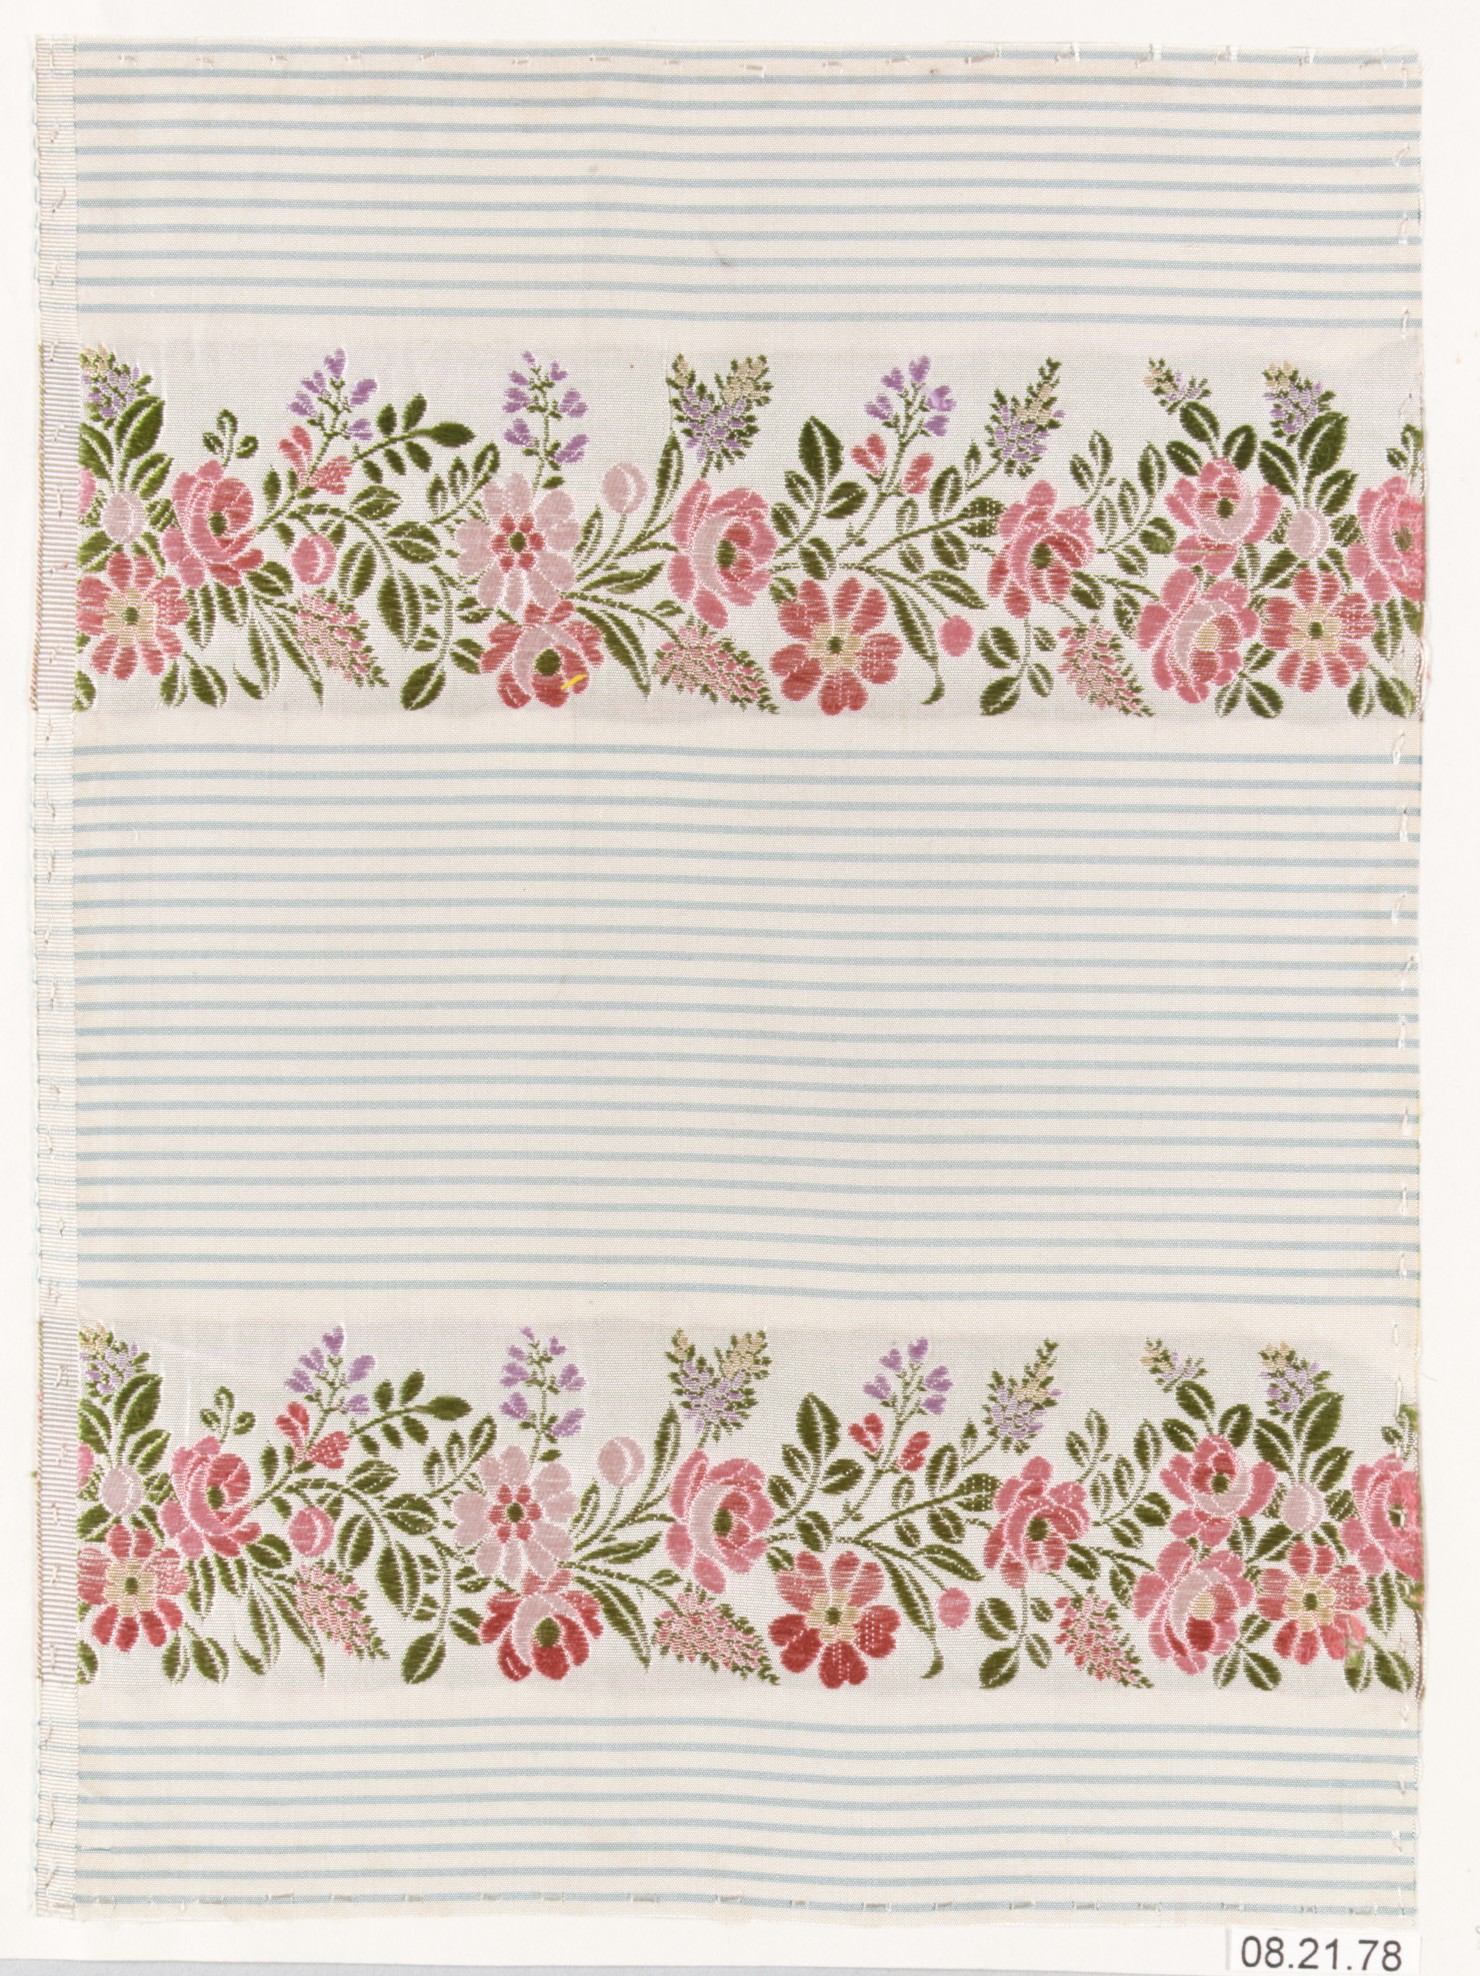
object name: textile sample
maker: Anonymous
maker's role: designer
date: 1900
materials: silk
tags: flowers